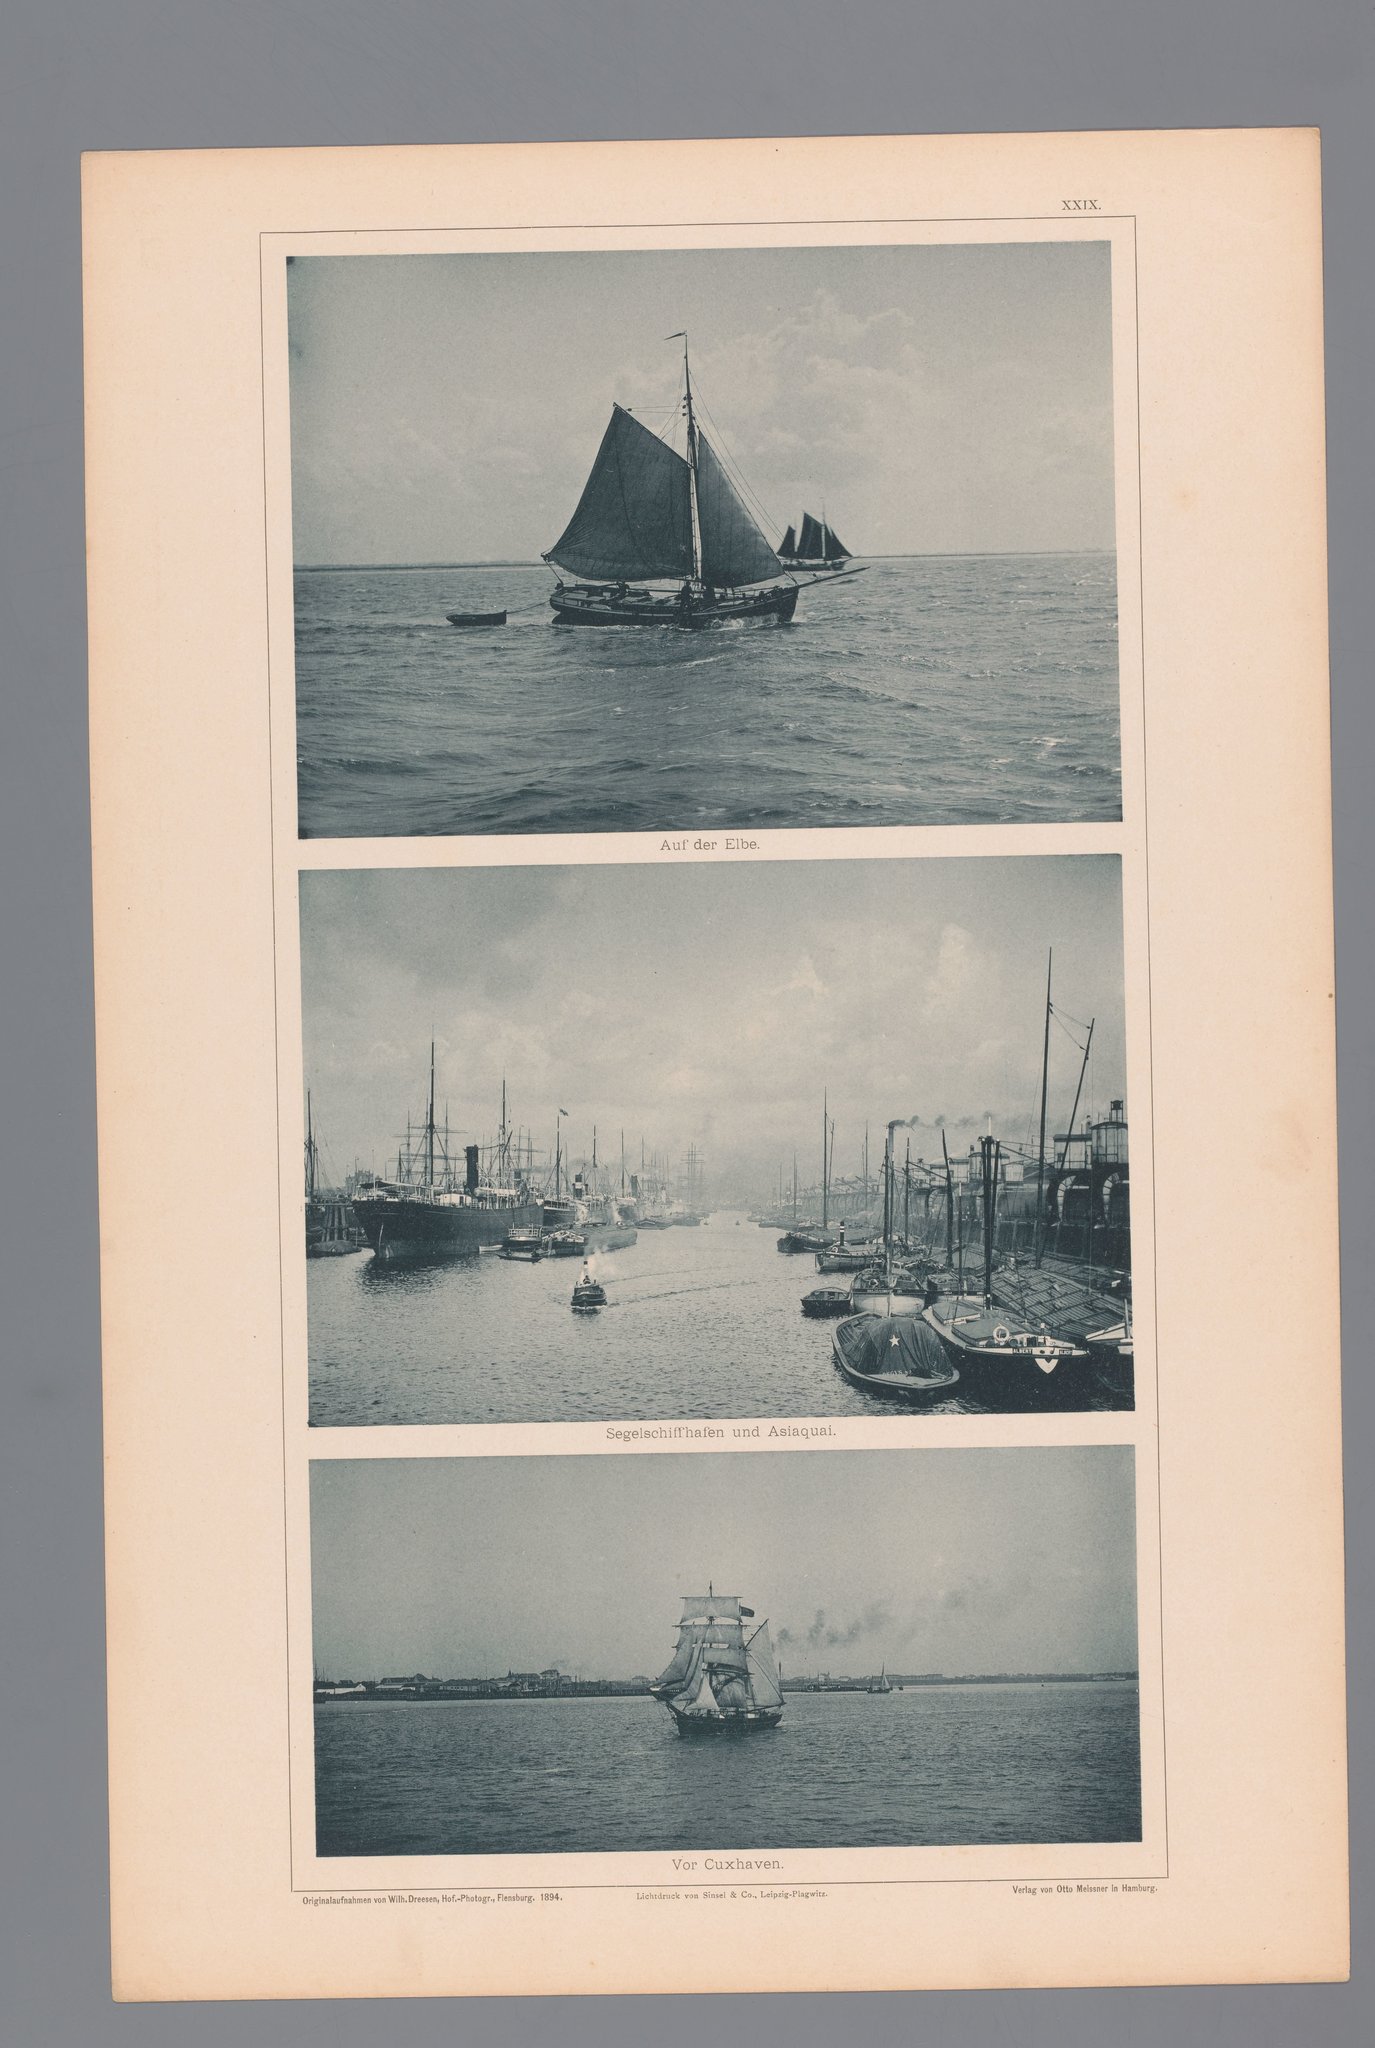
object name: photomechanical print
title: Drie afbeeldingen van een zeilschip op de Elbe, een gezicht op de haven van Hamburg en een zeilschip bij Cuxhaven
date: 1894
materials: paper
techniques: photograph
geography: leipzig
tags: harbour, sailing-ship, sailing-boat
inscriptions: number: ‘XXIX.’, inscription: ‘Originalaufnahmen von Wilh. Dreesen, Hof.-Photogr., Flensburg. 1894.’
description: Deze prenten maken deel uit van een omslag met 126 prenten op 37 bladen en een tekstblad.